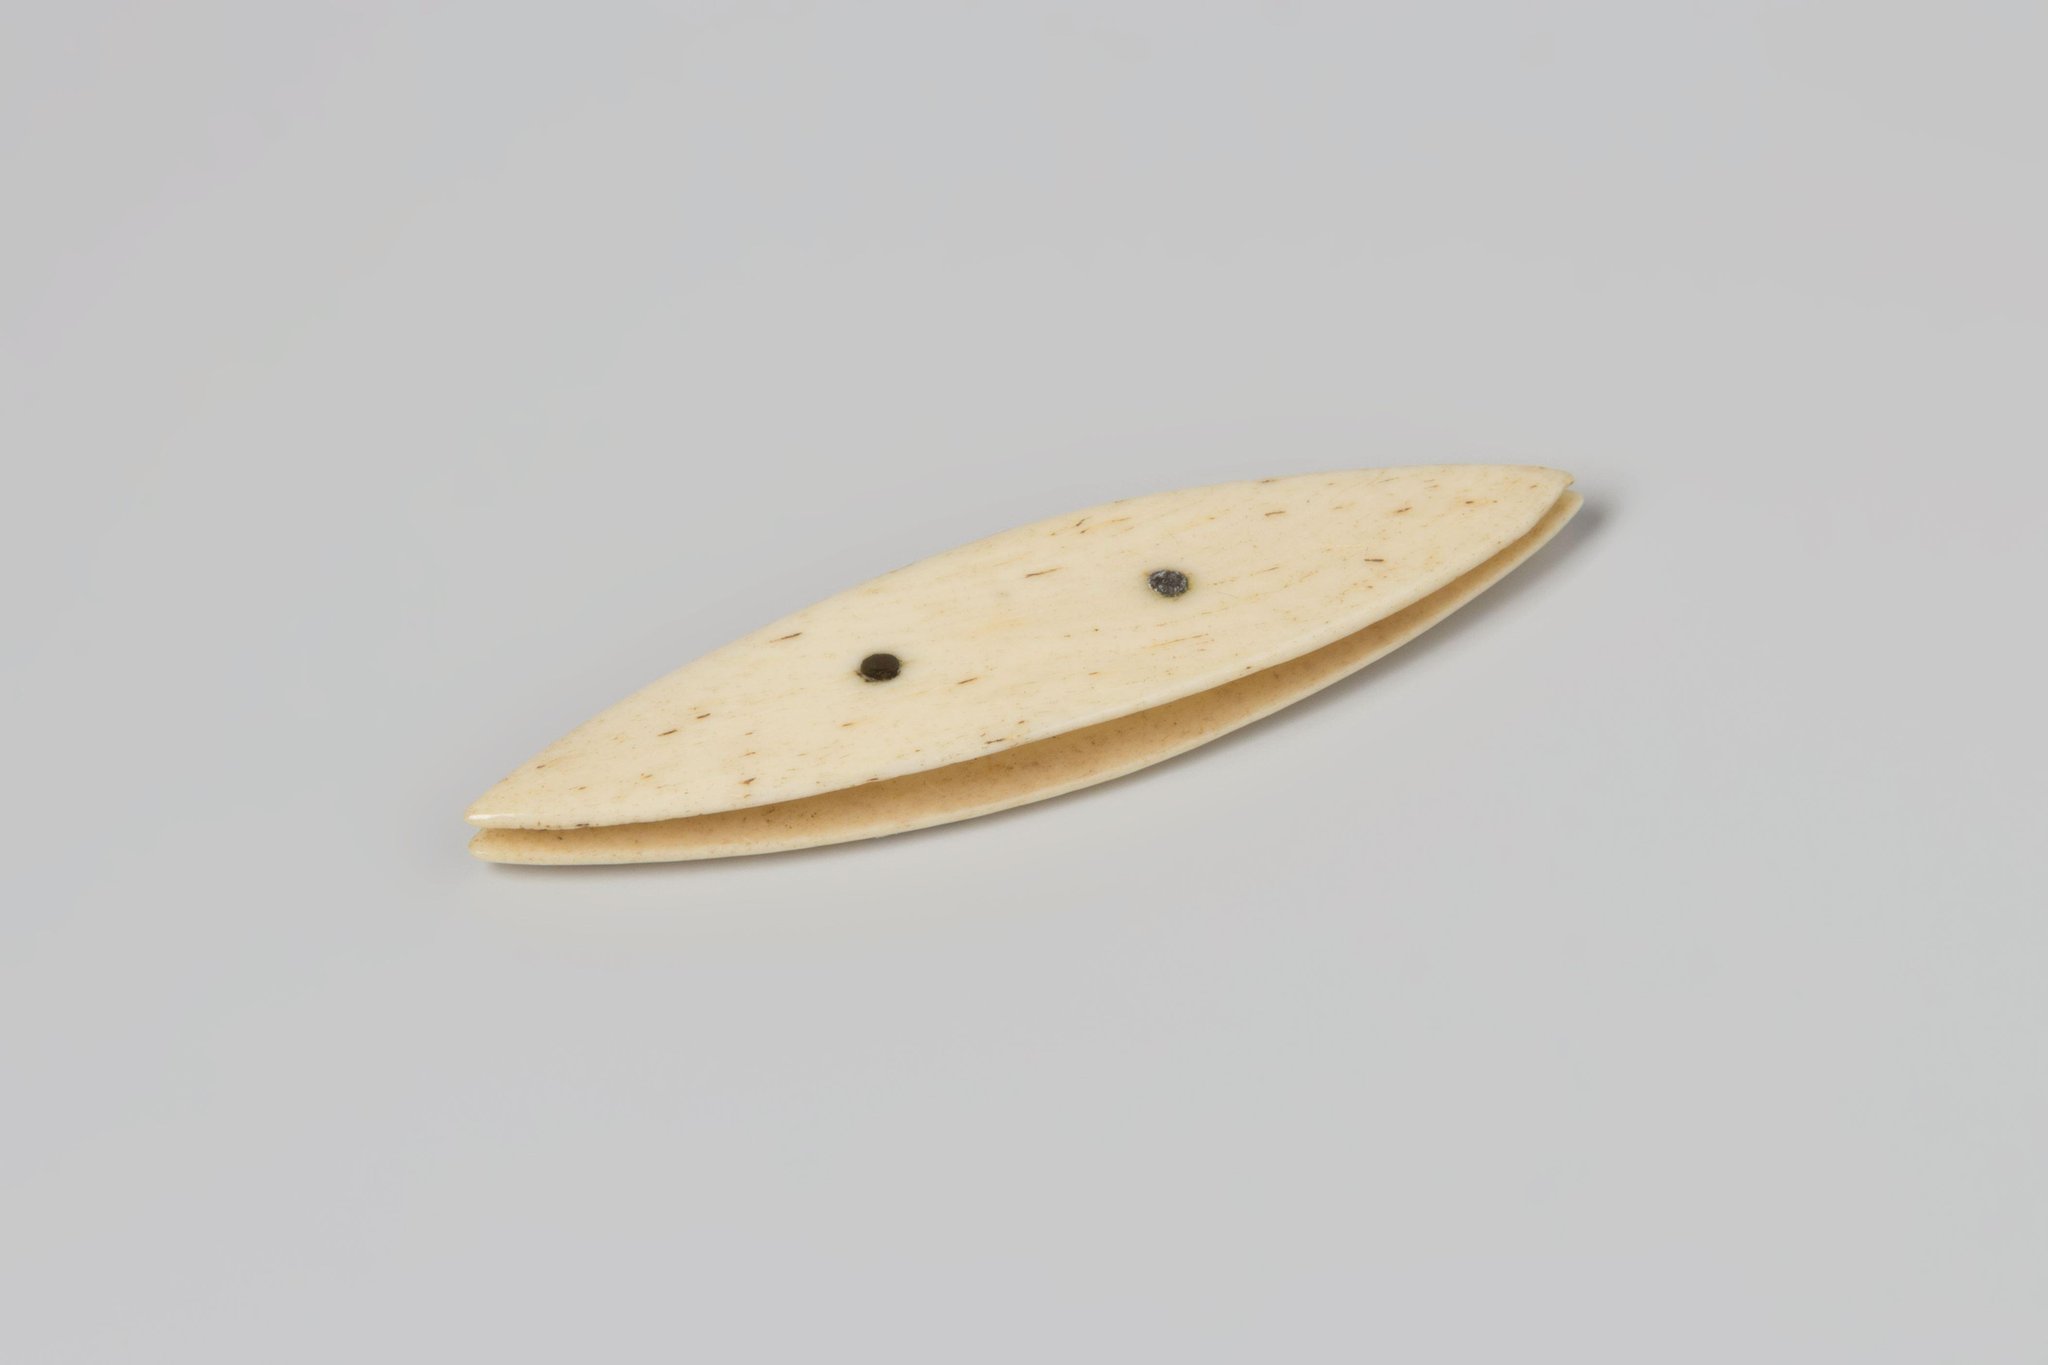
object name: sewing tool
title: Schuitje voor frivolitéwerk van been, met een blok tussen de twee schijven, bijeengehouden door twee metalen pinnen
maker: Anonymous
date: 1700-1900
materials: bone, metal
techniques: cutting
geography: western europe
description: Schuitje voor frivolitéwerk van been, met een blok tussen de twee schijven, bijeengehouden door twee metalen pinnen.